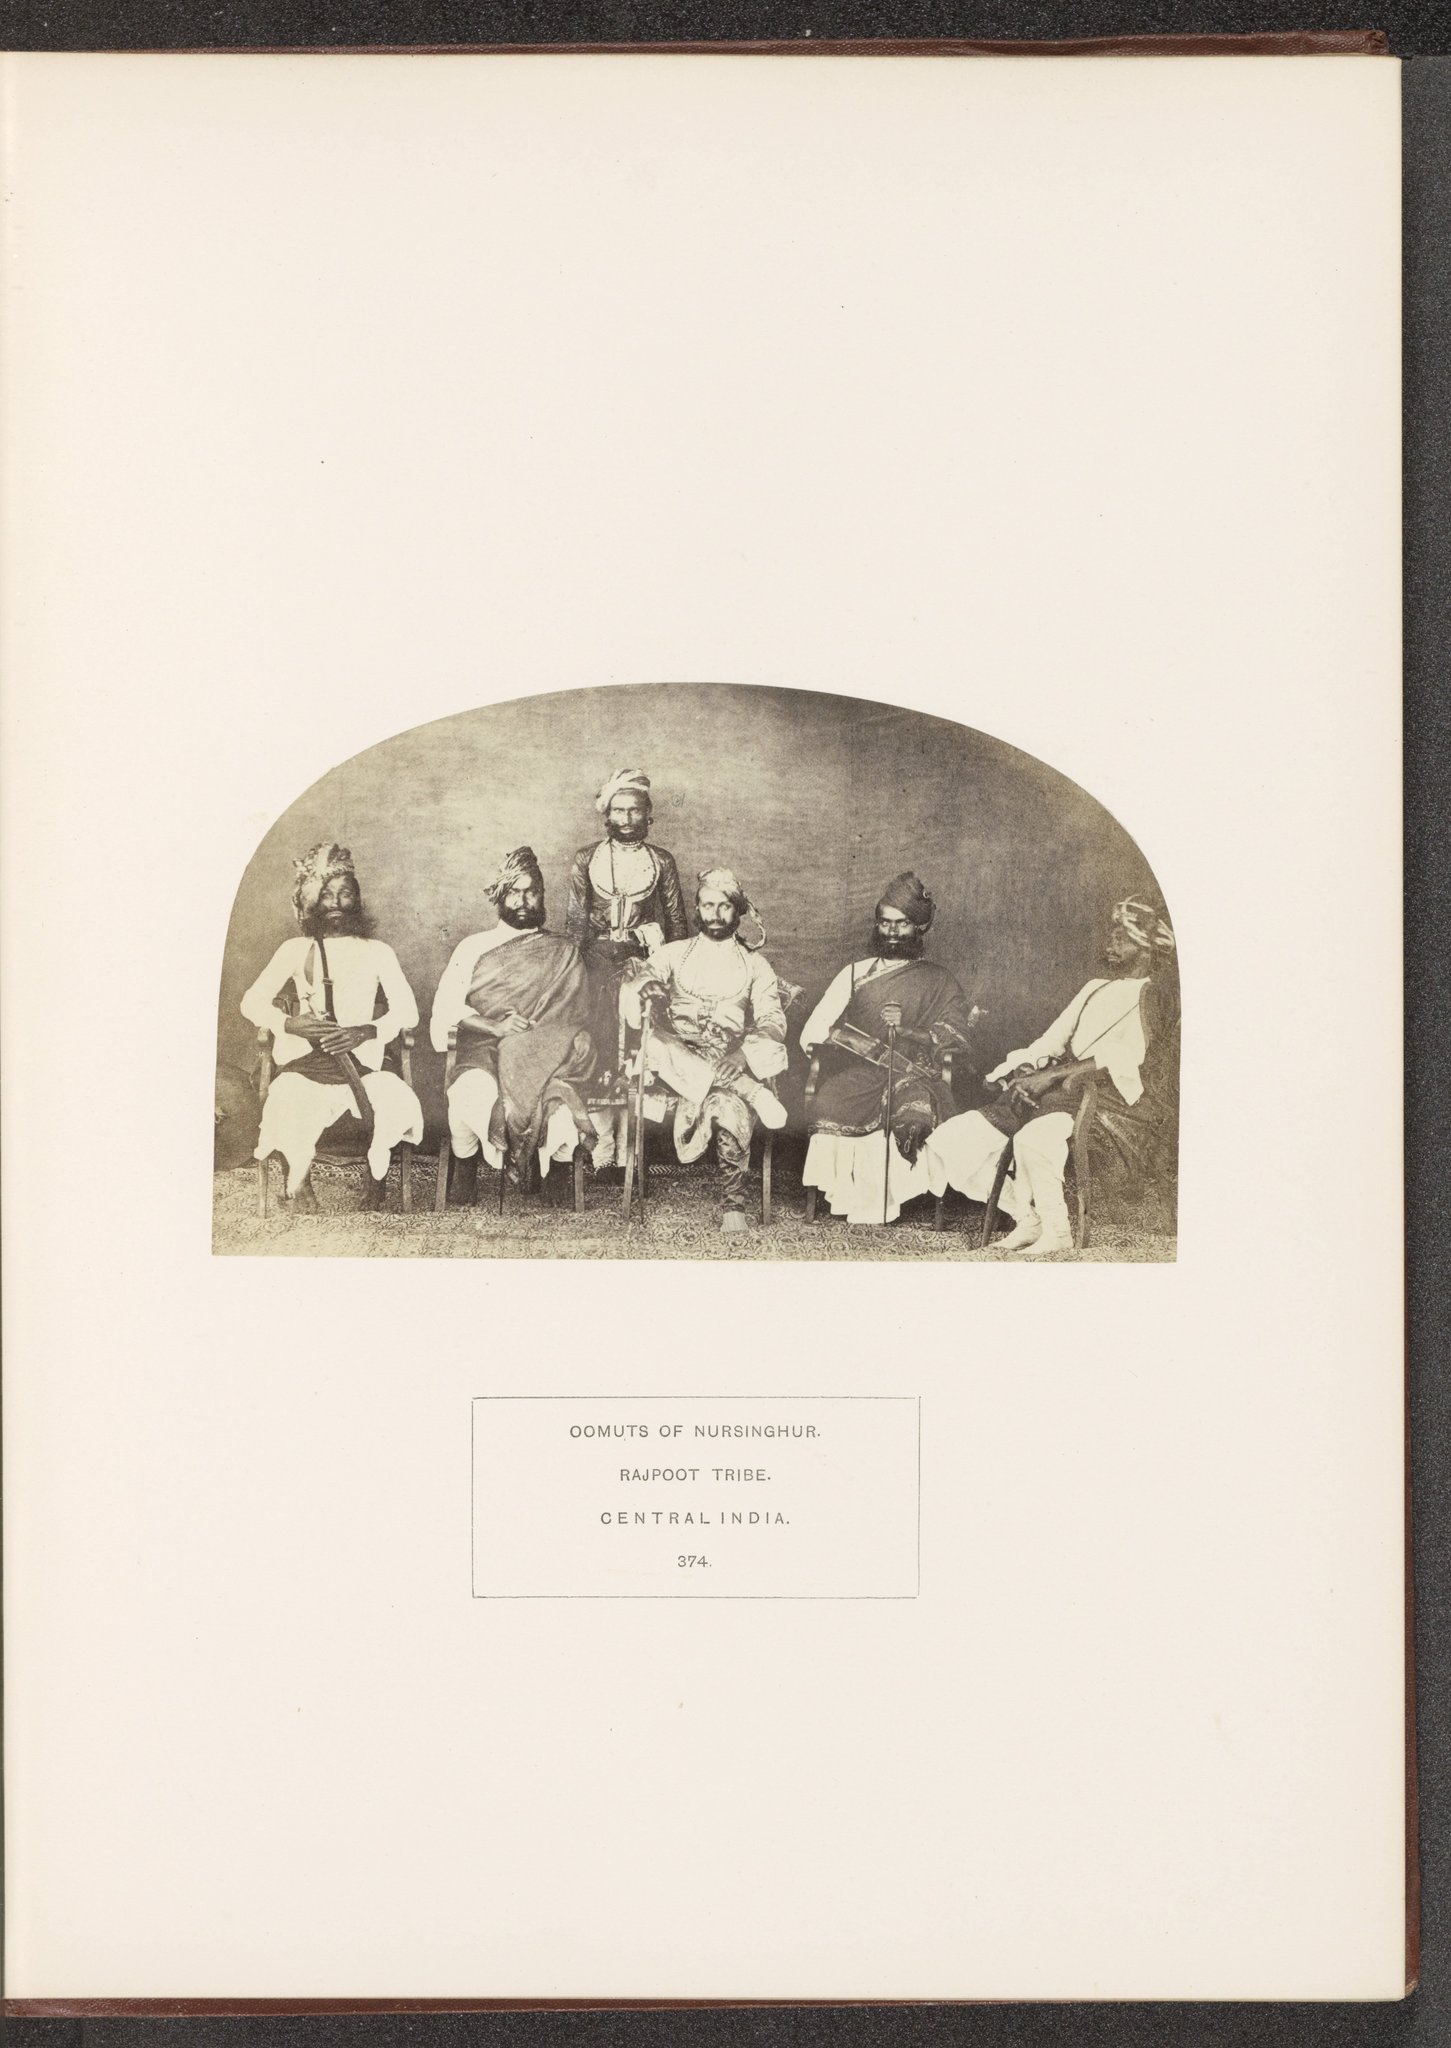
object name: page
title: Portrait of Koonwur Mytab Singh and five other men with turbans from Narsinghpur, Madhya Pradesh, India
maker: james john waterhouse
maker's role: fotograaf, luitenant, officier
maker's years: 1842-1928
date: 1862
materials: photographic support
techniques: albumen print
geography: narsinghpur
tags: head-gear: turban, ruler, sovereign, human races; peoples; nationalities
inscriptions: number: ‘374.’, inscription: ‘OOMUTS OF NURSINGHUR./ RAJPOOT TRIBE./ CENTRAL INDIA.’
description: De centrale figuur is Koonwur Mytab Singh, de zoon van de radja van Nursinghur.